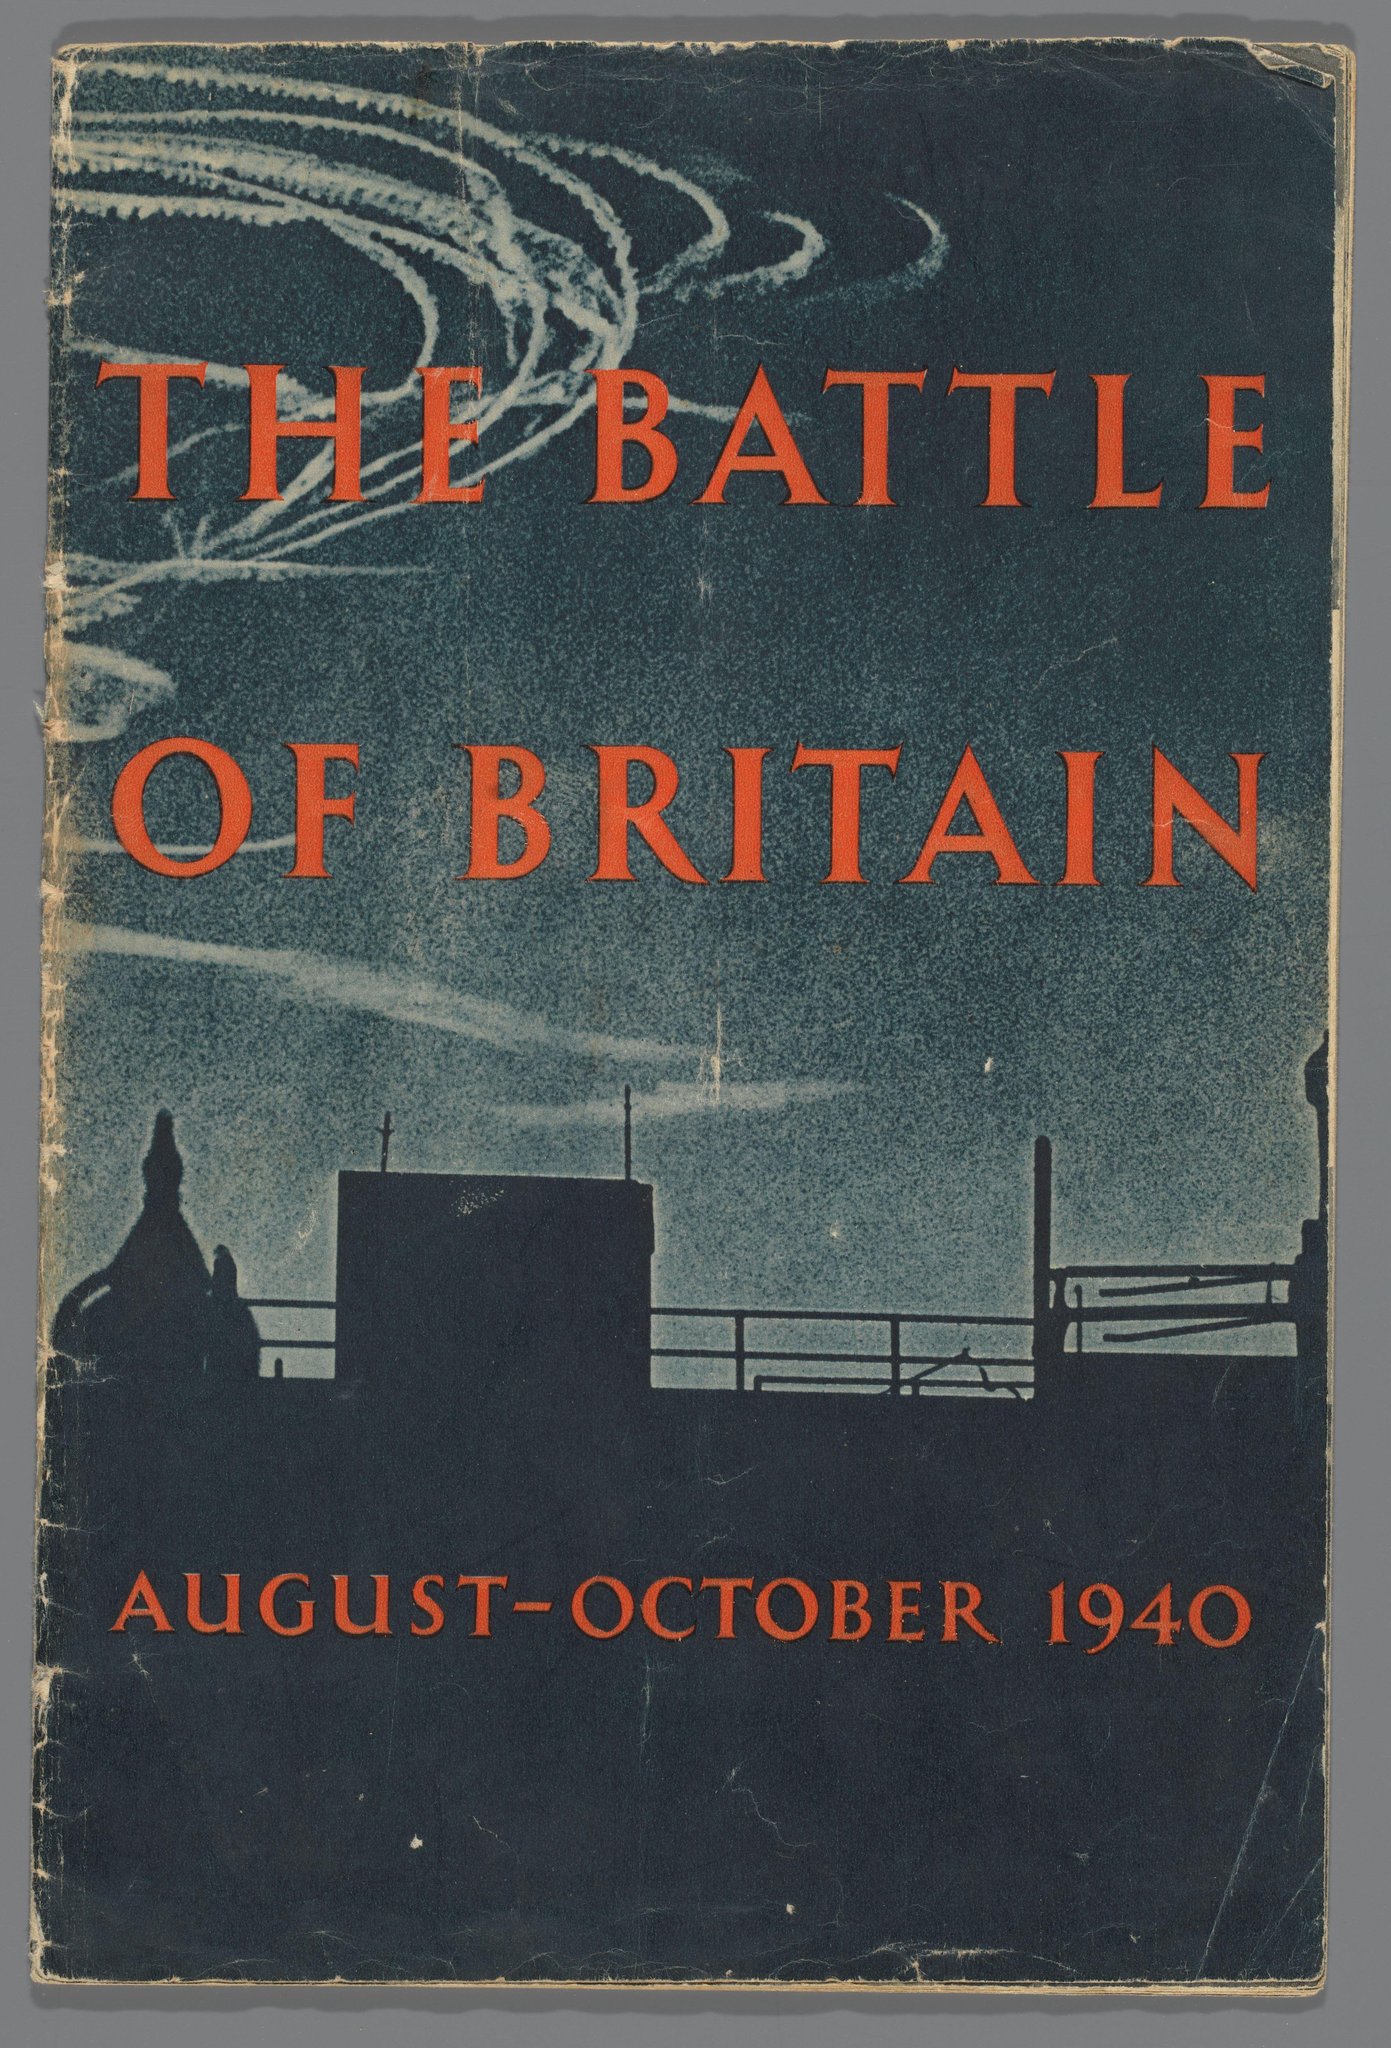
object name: book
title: The Battle of Britain August - October 1940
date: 1940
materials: paper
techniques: printing, stapling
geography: london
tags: england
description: Boek waarin verslag wordt gedaan van de 'Battle of Britain'. geïllustreerd met foto's en kaartjes.